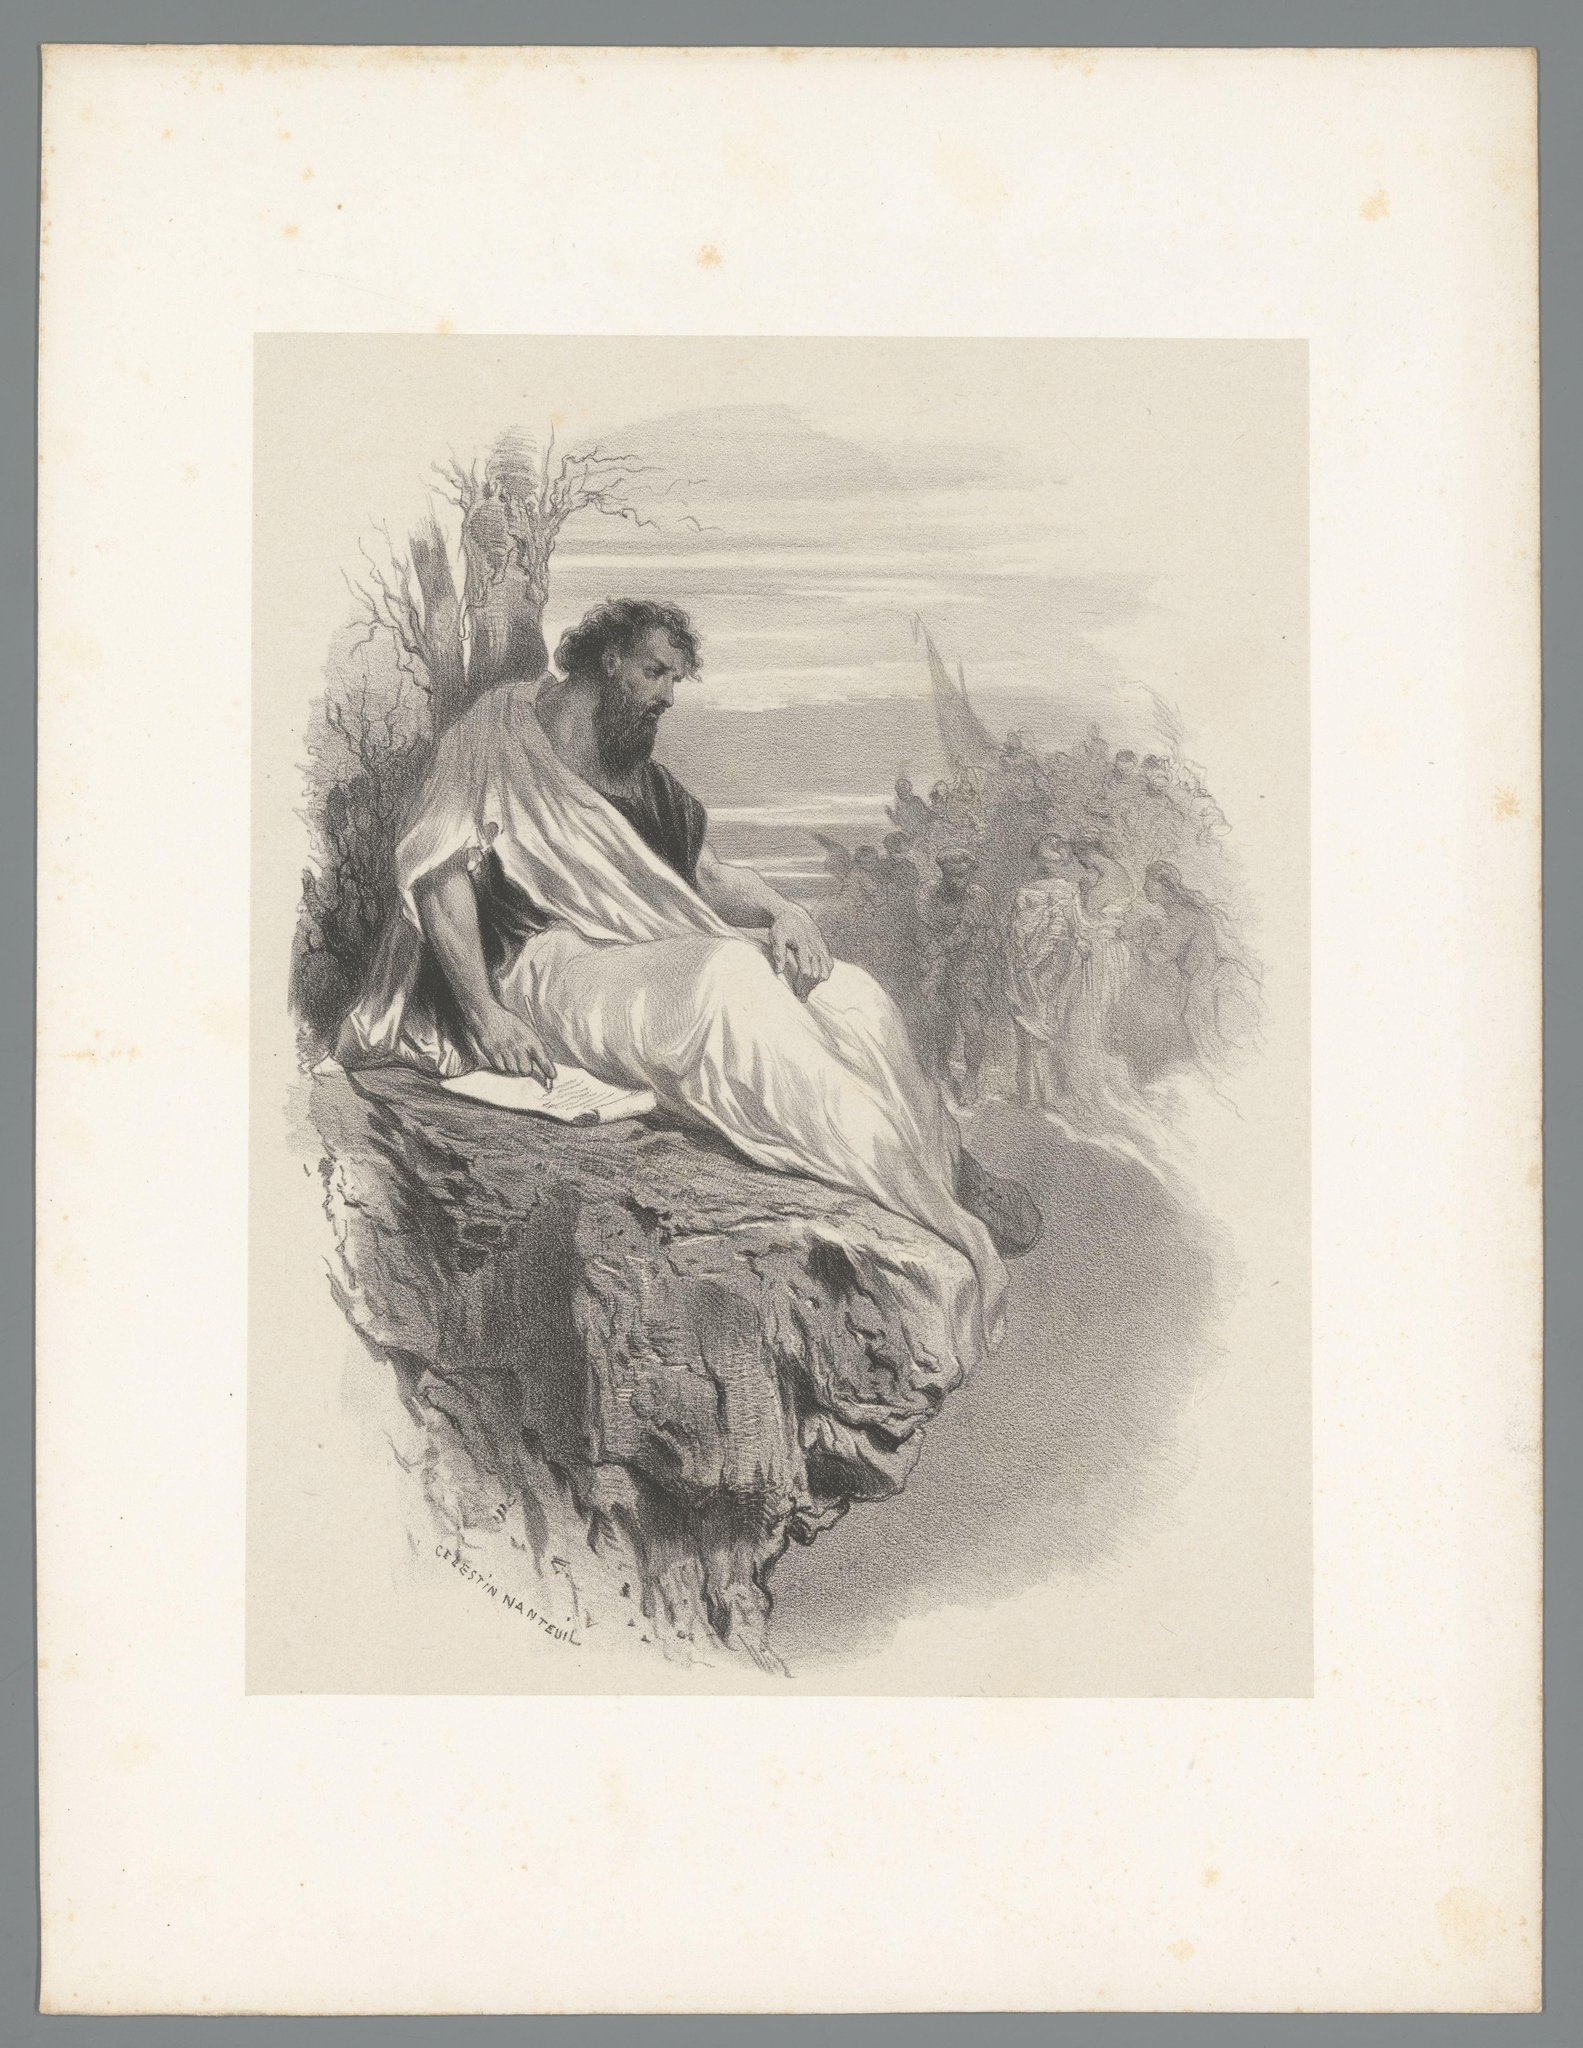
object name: print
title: Schrijvende man zittend op een rots, op de achtergrond een groep mensen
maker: célestin françois nanteuil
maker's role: print maker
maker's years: 1813-1873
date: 1823-1873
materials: paper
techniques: lithograph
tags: fashion, clothing, adult man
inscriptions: collector's mark: Lugt 964